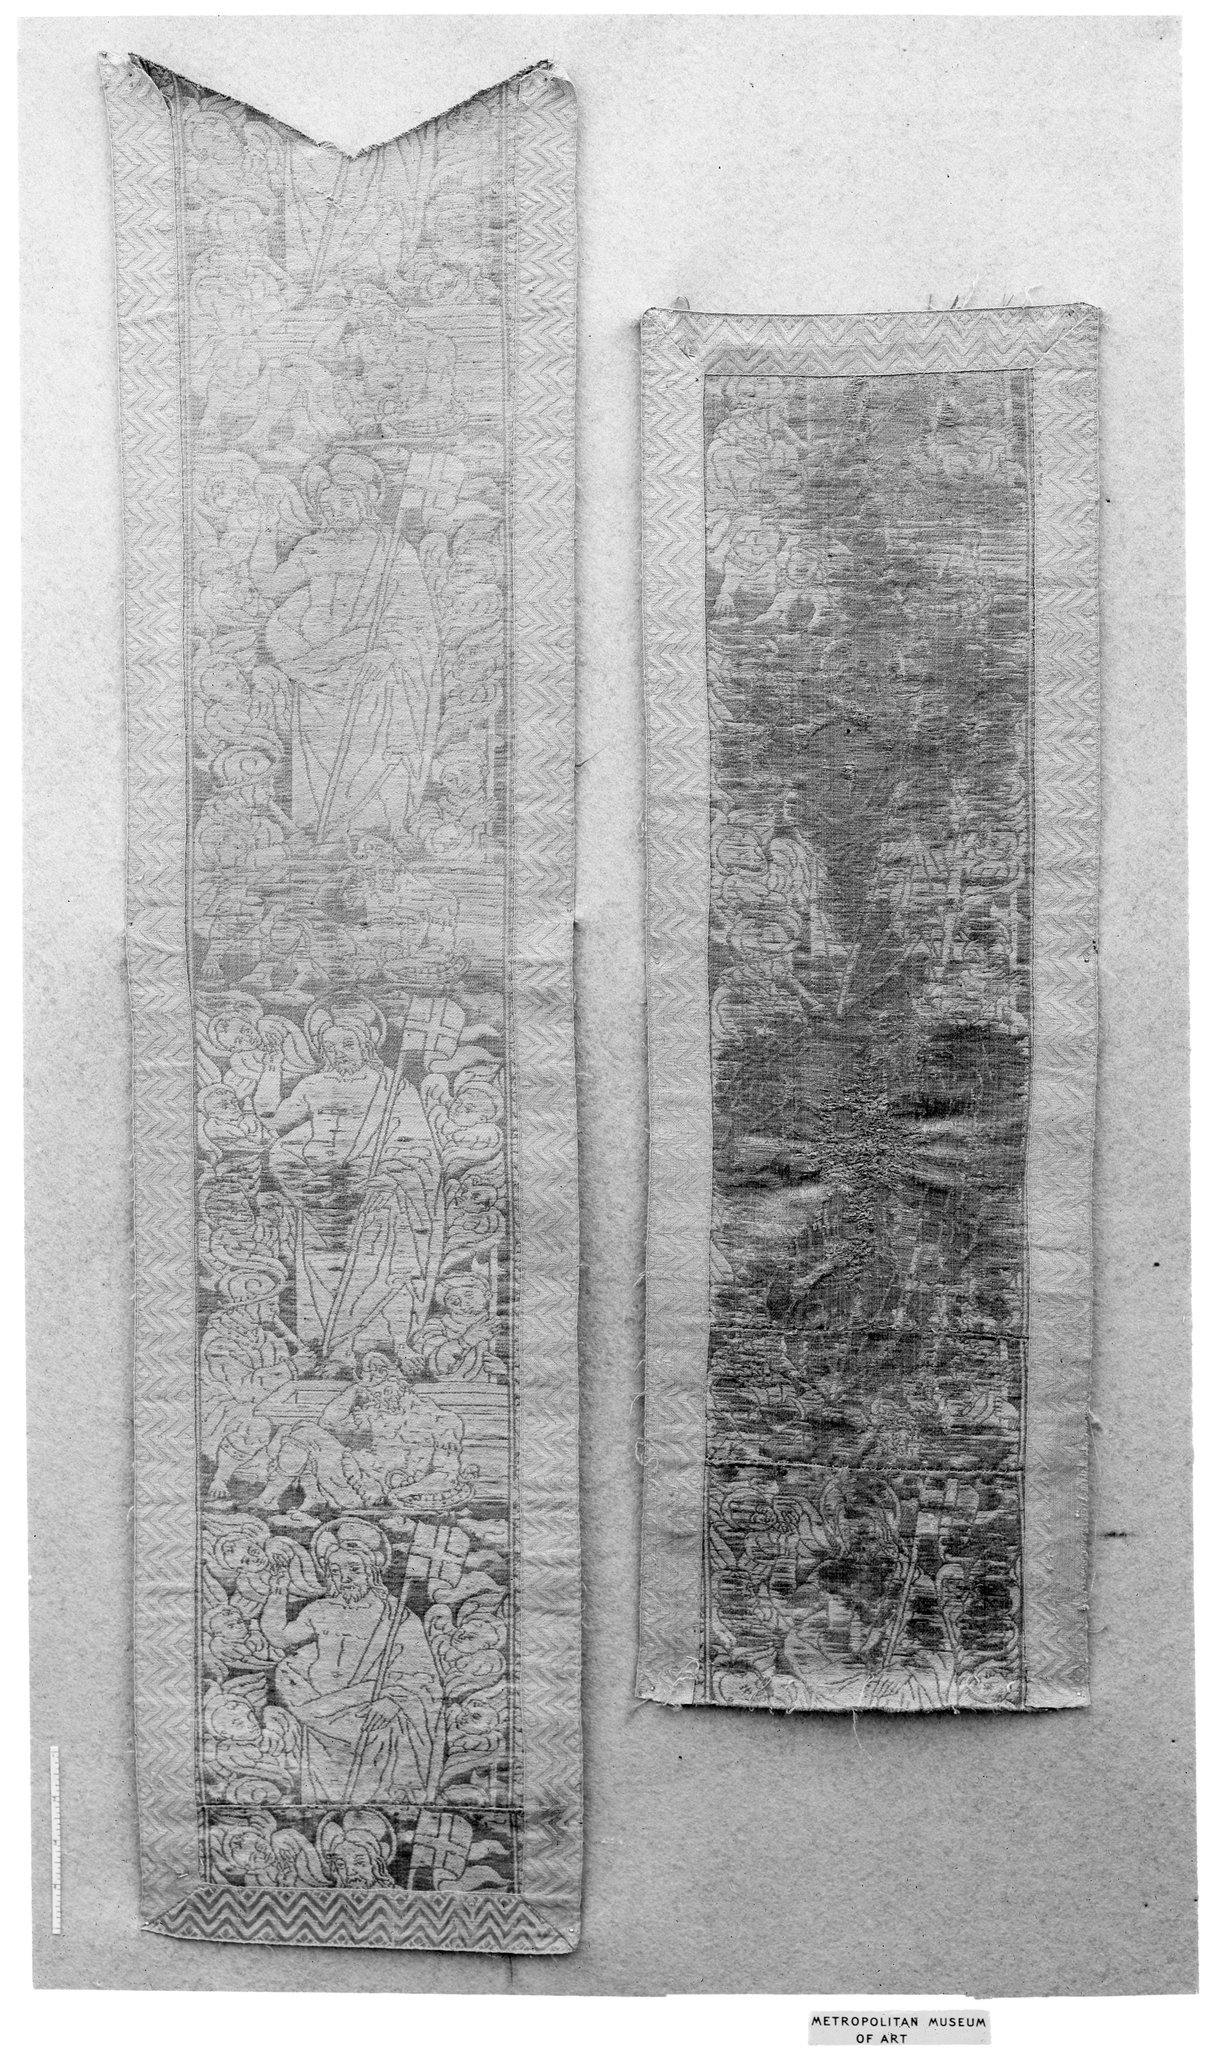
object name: orphrey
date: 1501-1600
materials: linen, silk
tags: christ